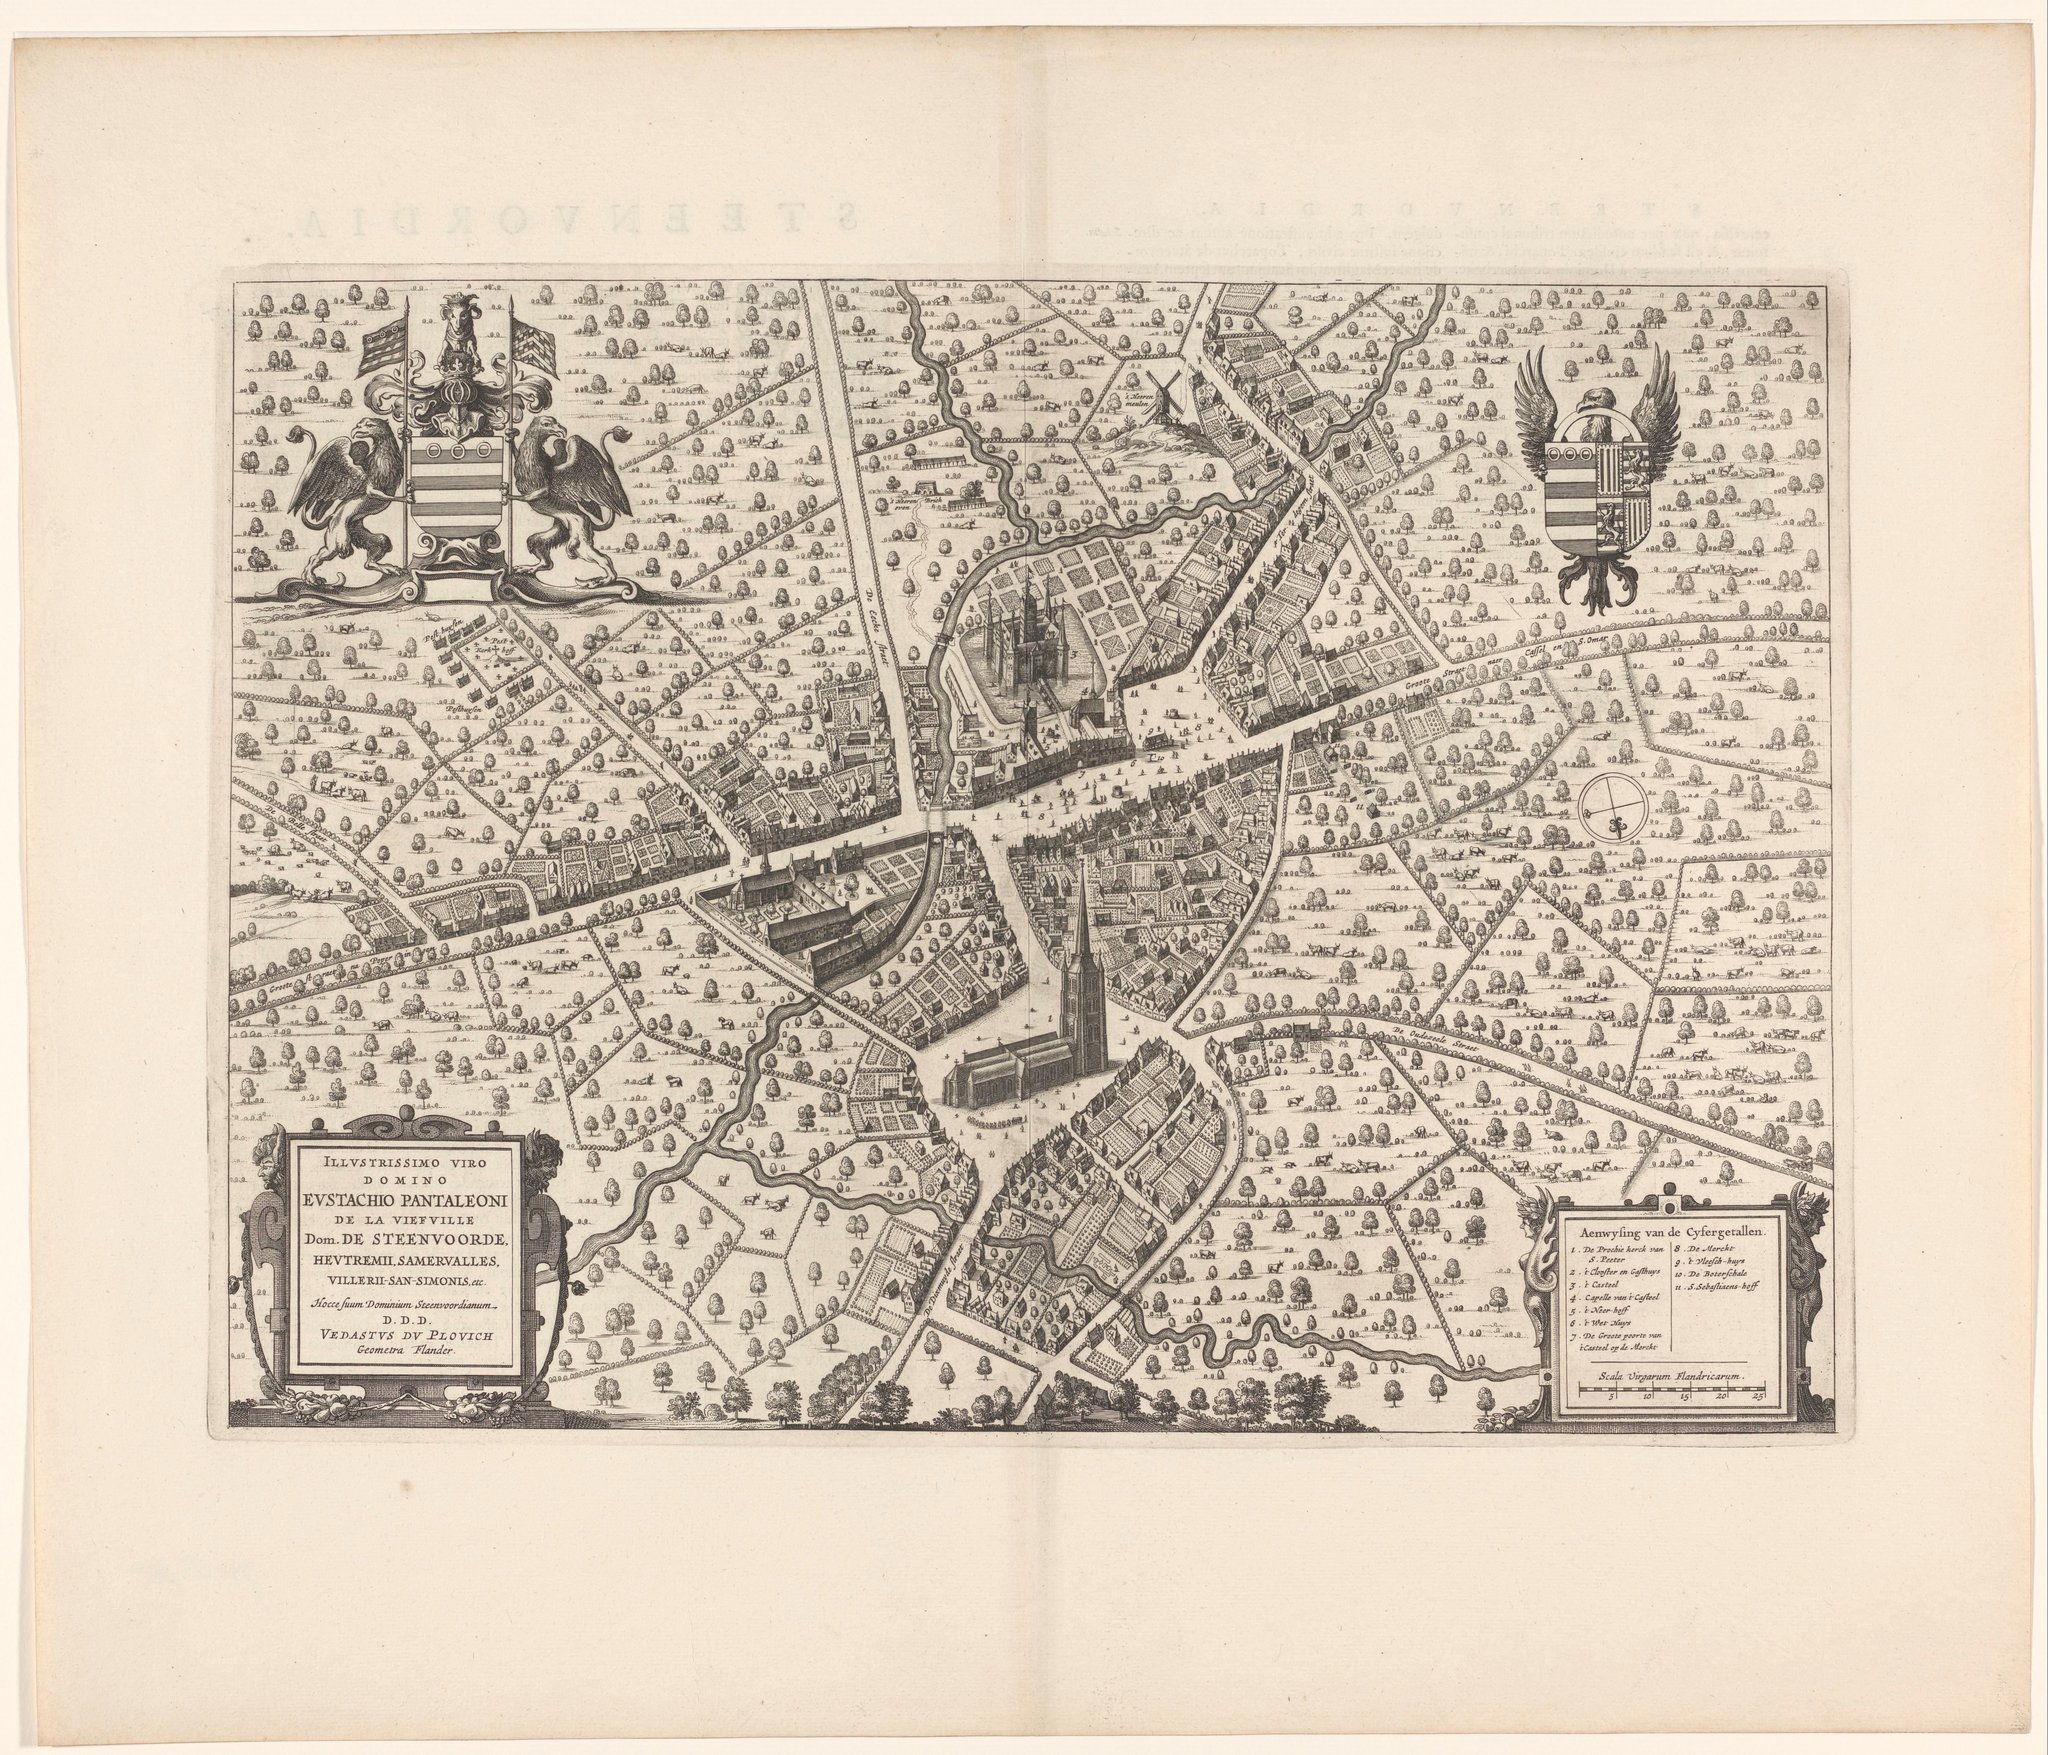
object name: print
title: Illustrissimo viro domino Eustachio Pantaleoni de la Viefville (...)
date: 1652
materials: paper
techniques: engraving, etching, letterpress printing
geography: amsterdam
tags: coat of arms (as symbol of the state, etc.) (+ city; municipal), prospect of city, town panorama, silhouette of city, armorial bearing, heraldry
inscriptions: collector's mark: Lugt 2228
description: Plattegrond van Steenvoorde in vogelvluchtperspectief. Rechtsonder een cartouche met legenda 1-11 en schaalstok: 25 Scala virgarum Flandricarum. Linksonder een cartouche met opdracht. Rechtsboven het wapen van Steenvoorde. Linksboven het familiewapen van La Viefville. Met Latijnse tekst op verso.